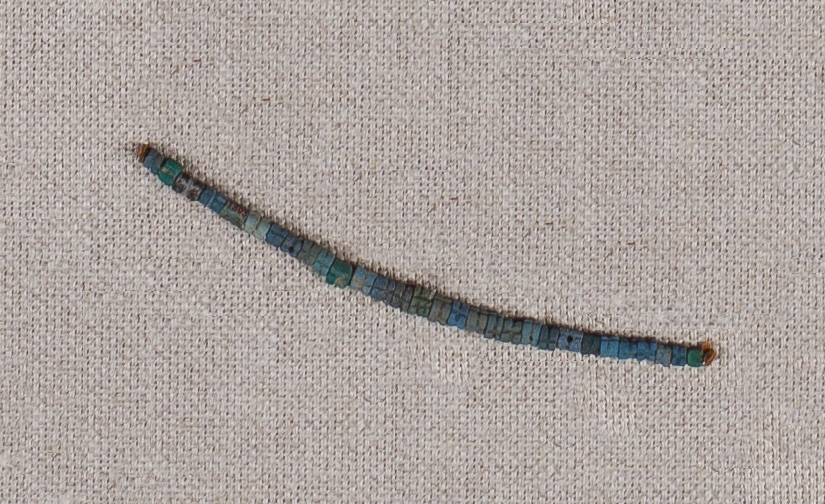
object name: necklace, bead, girdle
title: String of beads from girdle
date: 1981-1295 BCE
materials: paste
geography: egypt